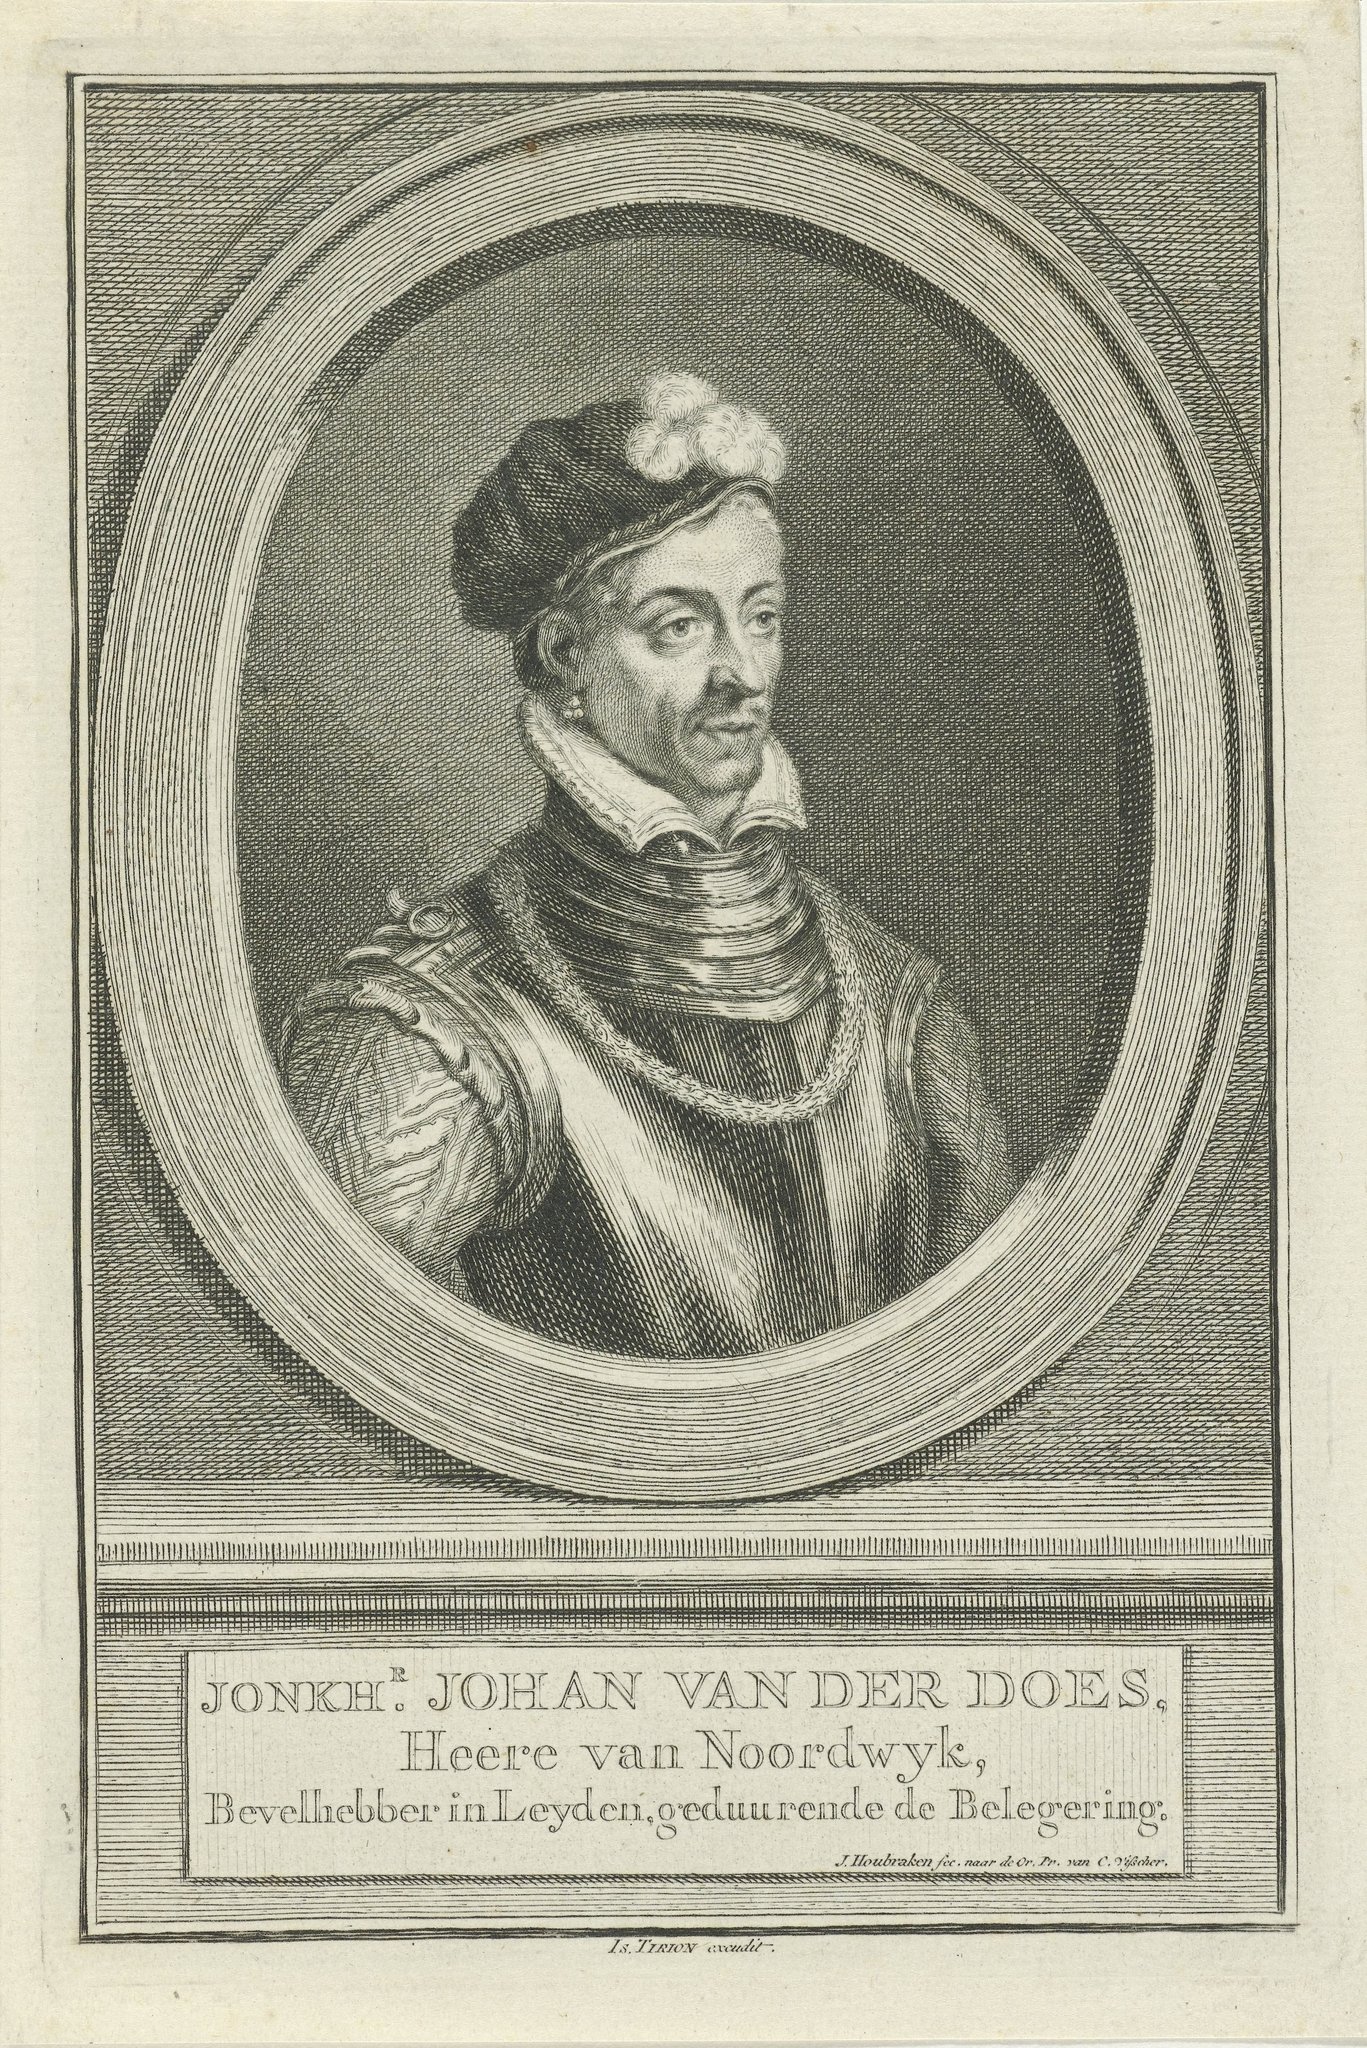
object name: print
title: Jonkhr. Johan van der Does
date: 1749-1759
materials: paper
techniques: engraving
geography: amsterdam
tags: bevelhebber, dichter, filoloog, bibliothecaris, bestuurder, jan van der does (heer van noordwijk en kattendijke)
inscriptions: collector's mark: Lugt 2228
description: Prent ook gebruikt in: Jan Wagenaar, Vaderlandsche historie, vervattende de geschiedenissen der nu Vereenigde Nederlanden, inzonderheid die van Holland (...), 21 delen. Amsterdam, Isaak Tirion, 1749-59.